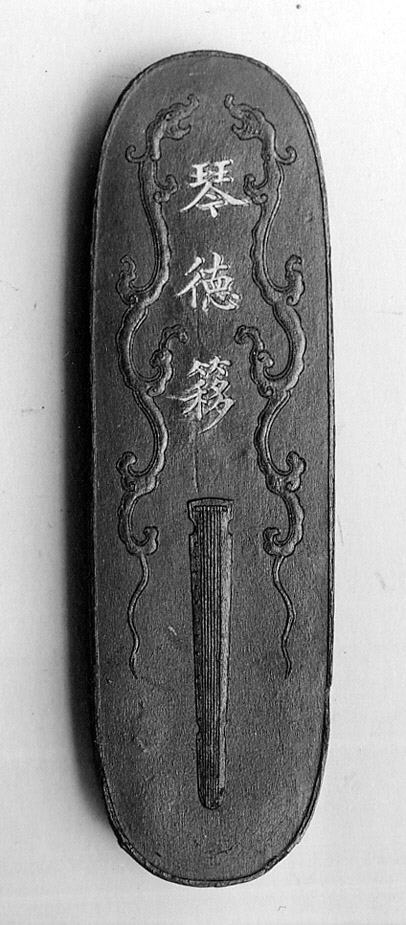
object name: ink tablet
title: The Harp Virtue Chamber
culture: chinese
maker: jian guzhai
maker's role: artist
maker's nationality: chinese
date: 1867-1933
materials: ink